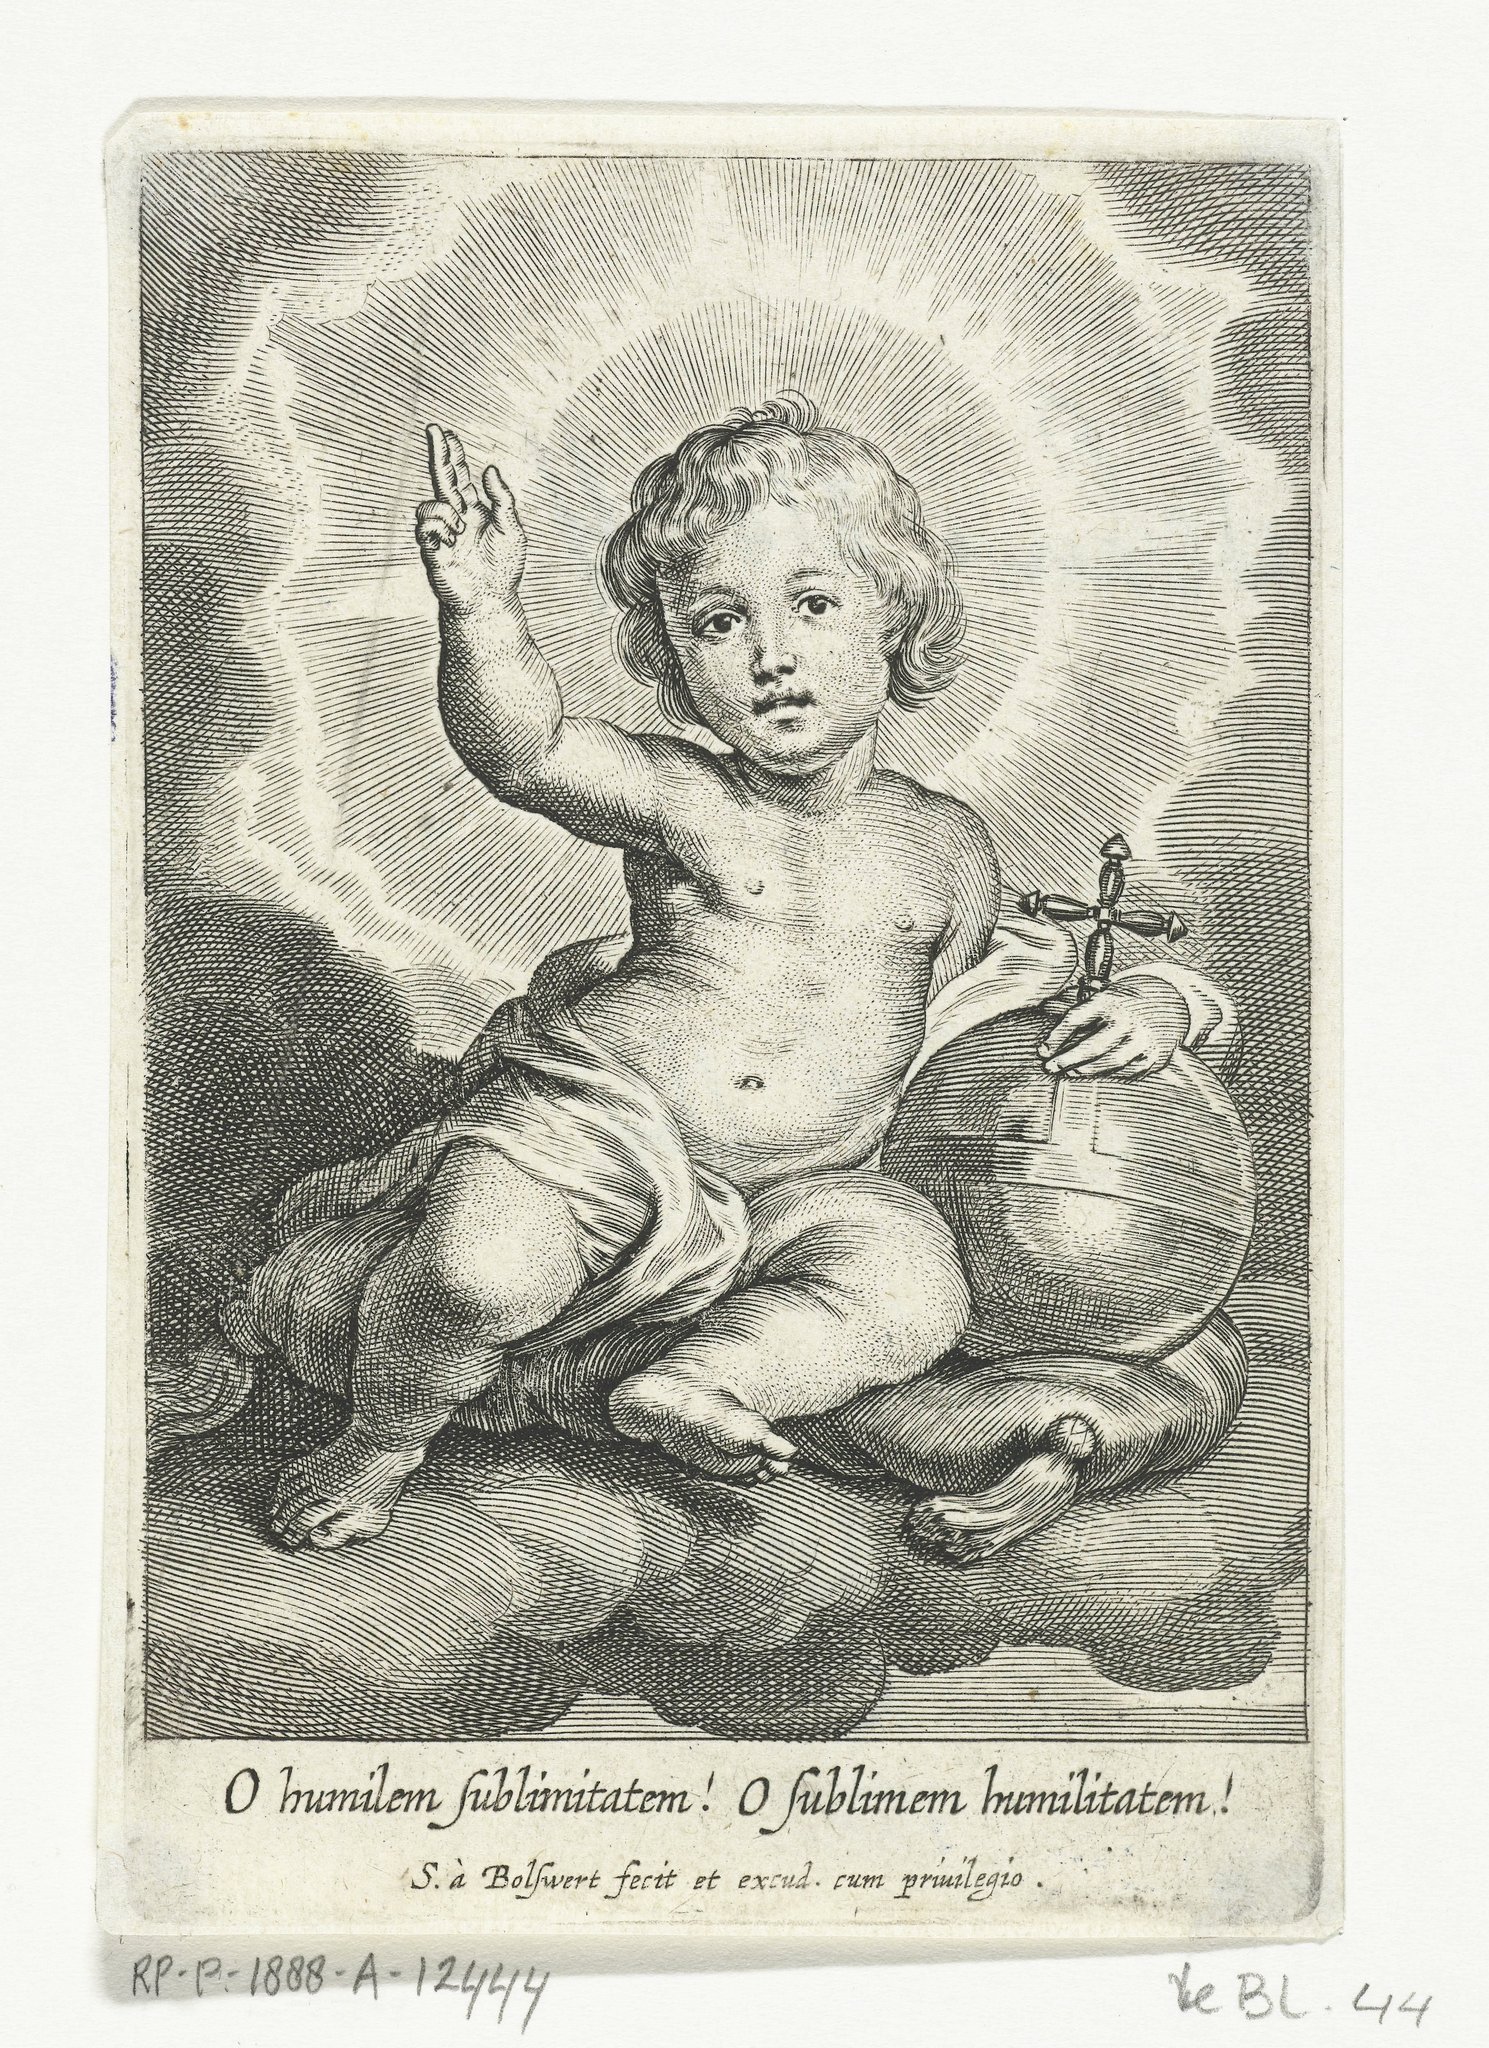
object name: print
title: Vélins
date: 1596-1659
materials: paper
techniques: engraving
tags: christ-child ~ types of adult christ, 'salvator mundi', making a blessing gesture; an orb in his hand or at his feet - dd - christ beardless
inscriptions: collector's mark: Lugt 2228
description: Prent uit serie Vélins met negentig prenten naar ontwerp van Peter Paul Rubens. In de bronnen vinden we uiteenlopende gegevens over aantal en samenstelling van de serie. Hollstein hanteert het aantal van negentig prenten. De reeks Vélins in de collectie van het RMA bevat verschillende staten afkomstig uit meerdere uitgaven welke moeilijk te duiden zijn. Sommige dragen het originele adres van Schelte Adamsz. Bolswert als graveur en uitgever, op andere exemplaren is deze naam verwijderd (duidelijk zichtbaar!) en vervangen door de naam Cornelis Galle (II). De prenten met de naam van uitgever Galle zijn vaak opgewerkt. We treffen nog een andere naam van een uitgever bij enkele prent aan: Martien van den Enden. Herkomst uit meerdere uitgaven spreekt ook uit afwijkende opschriften in Nederlands en Latijn en variaties op dezelfde thema's welke misschien nooit langs elkaar in dezelfde serie gebruikt werden.